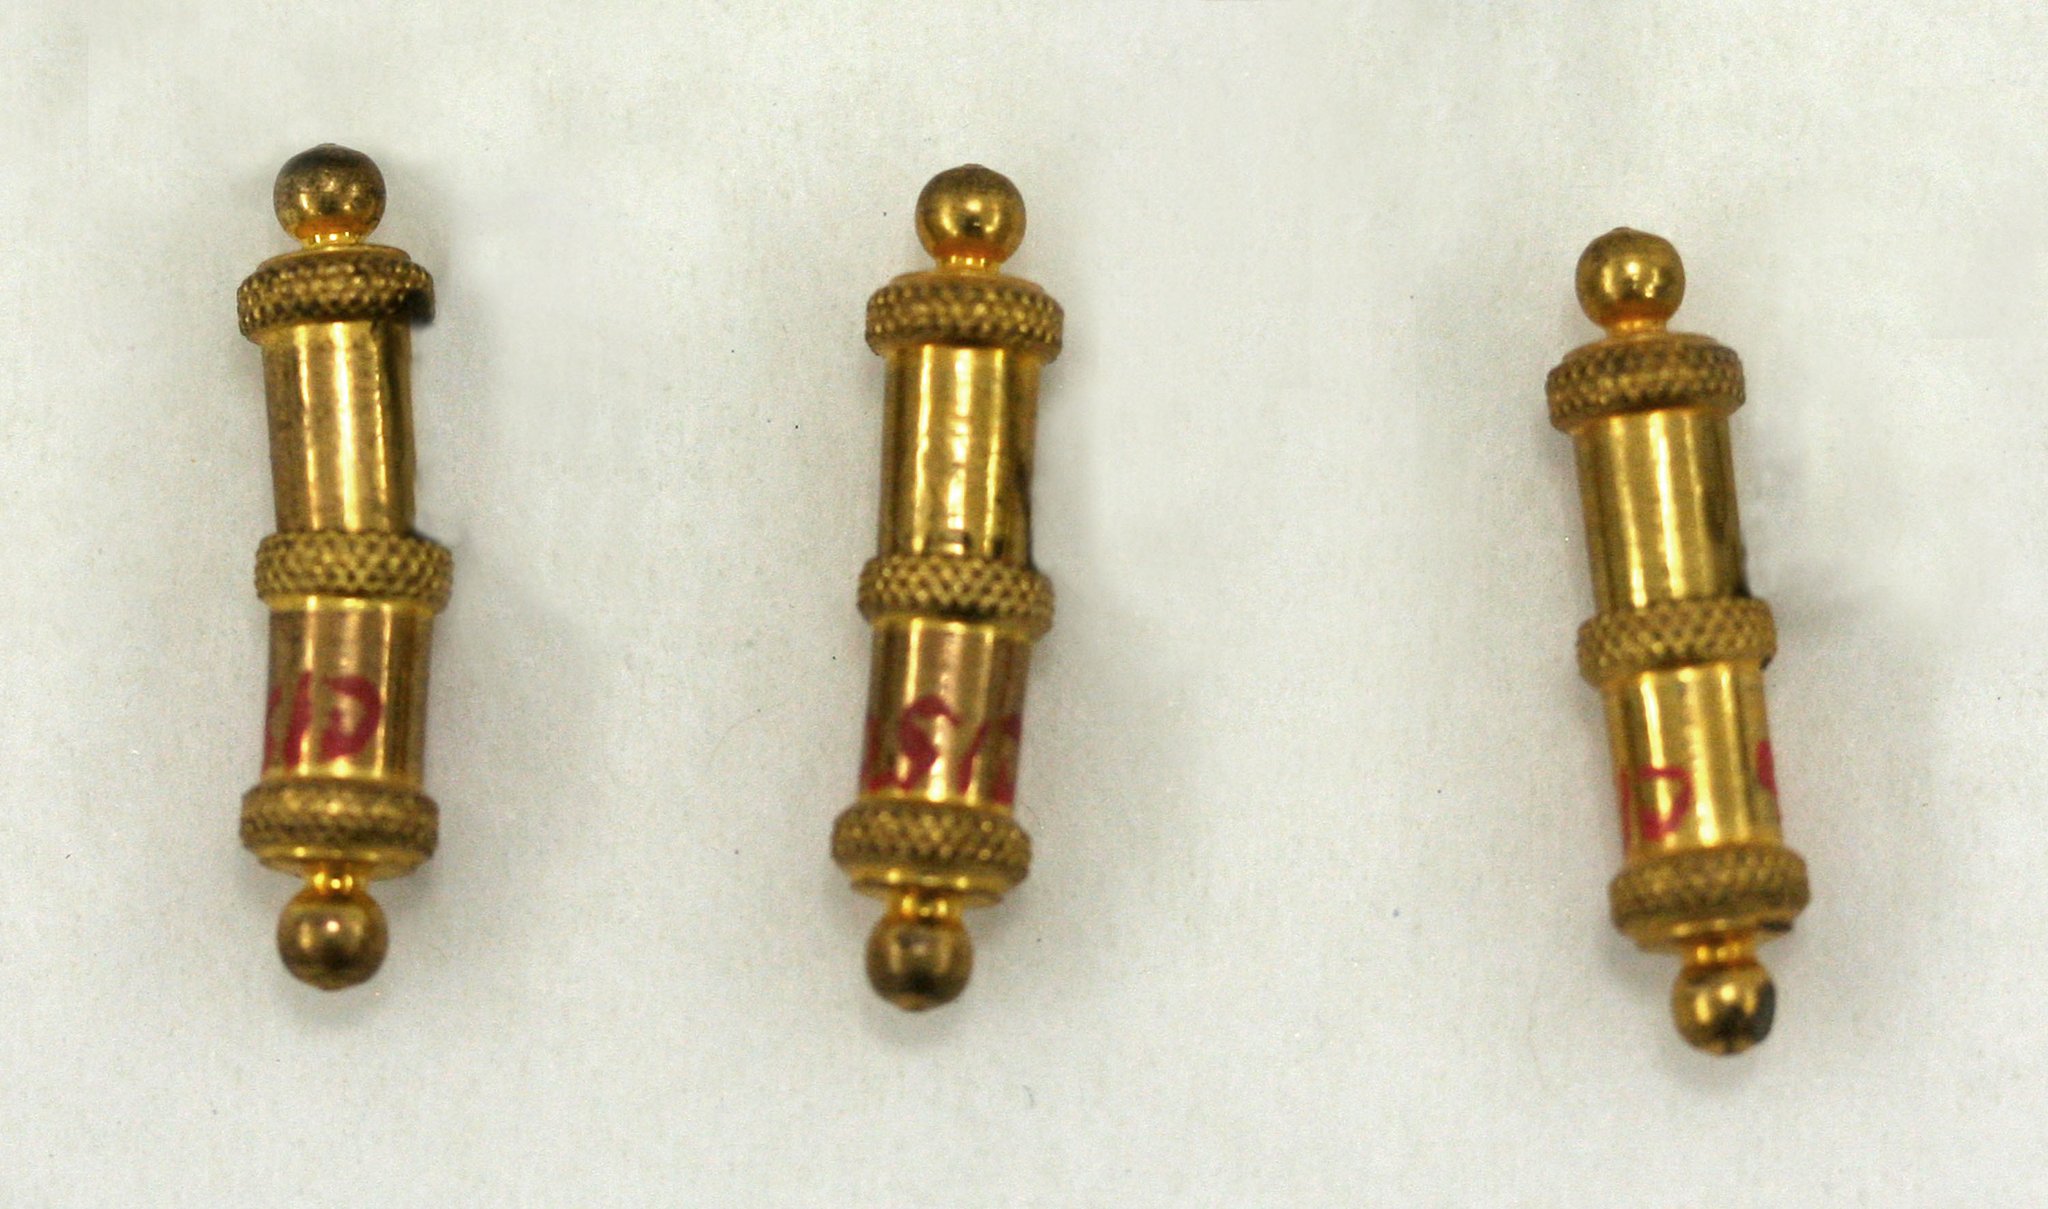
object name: jewellery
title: Jewelry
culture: american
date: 1867-1900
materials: gold